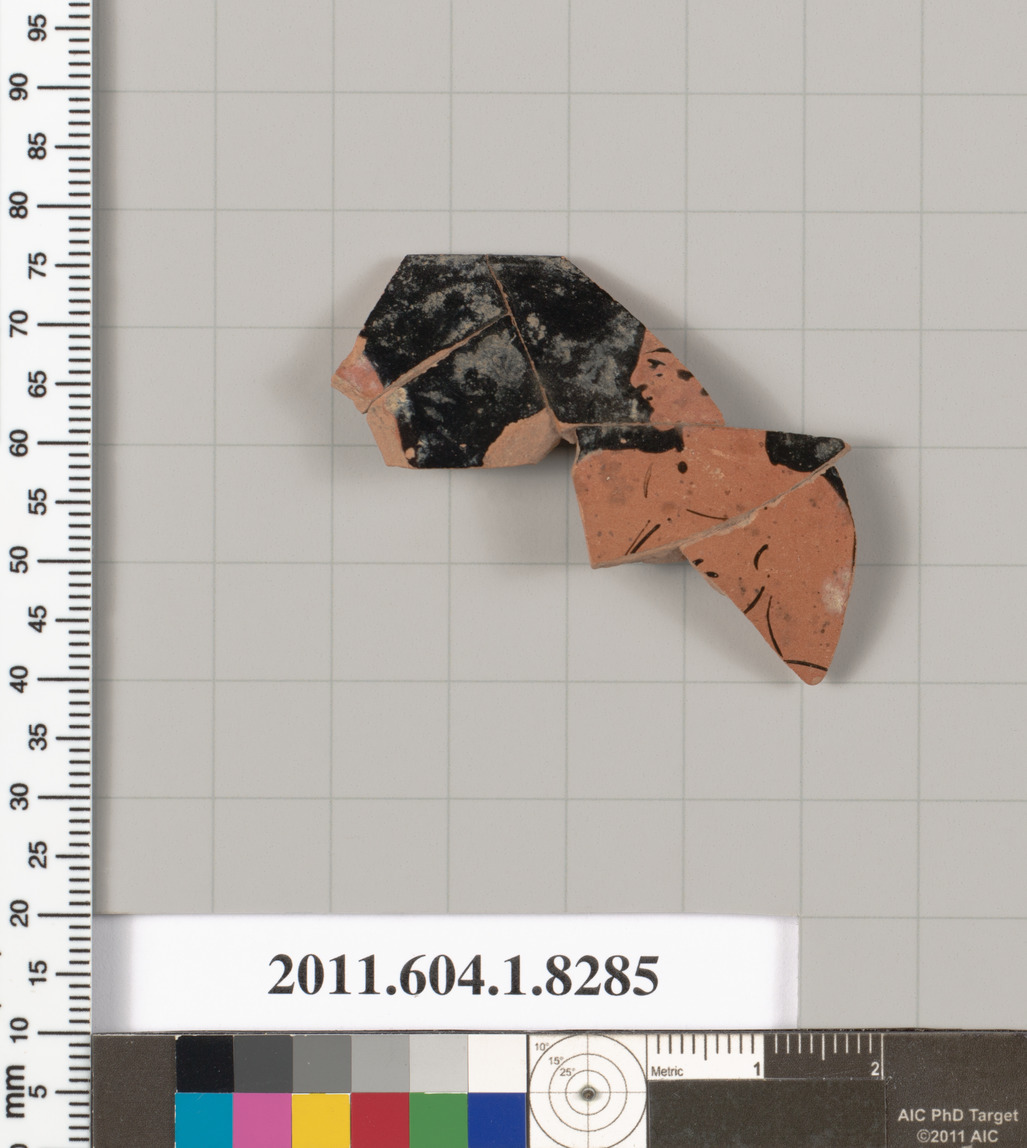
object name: kylix fragment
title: Terracotta rim fragment of a kylix (drinking cup)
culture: greek, attic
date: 425-401 BCE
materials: terracotta